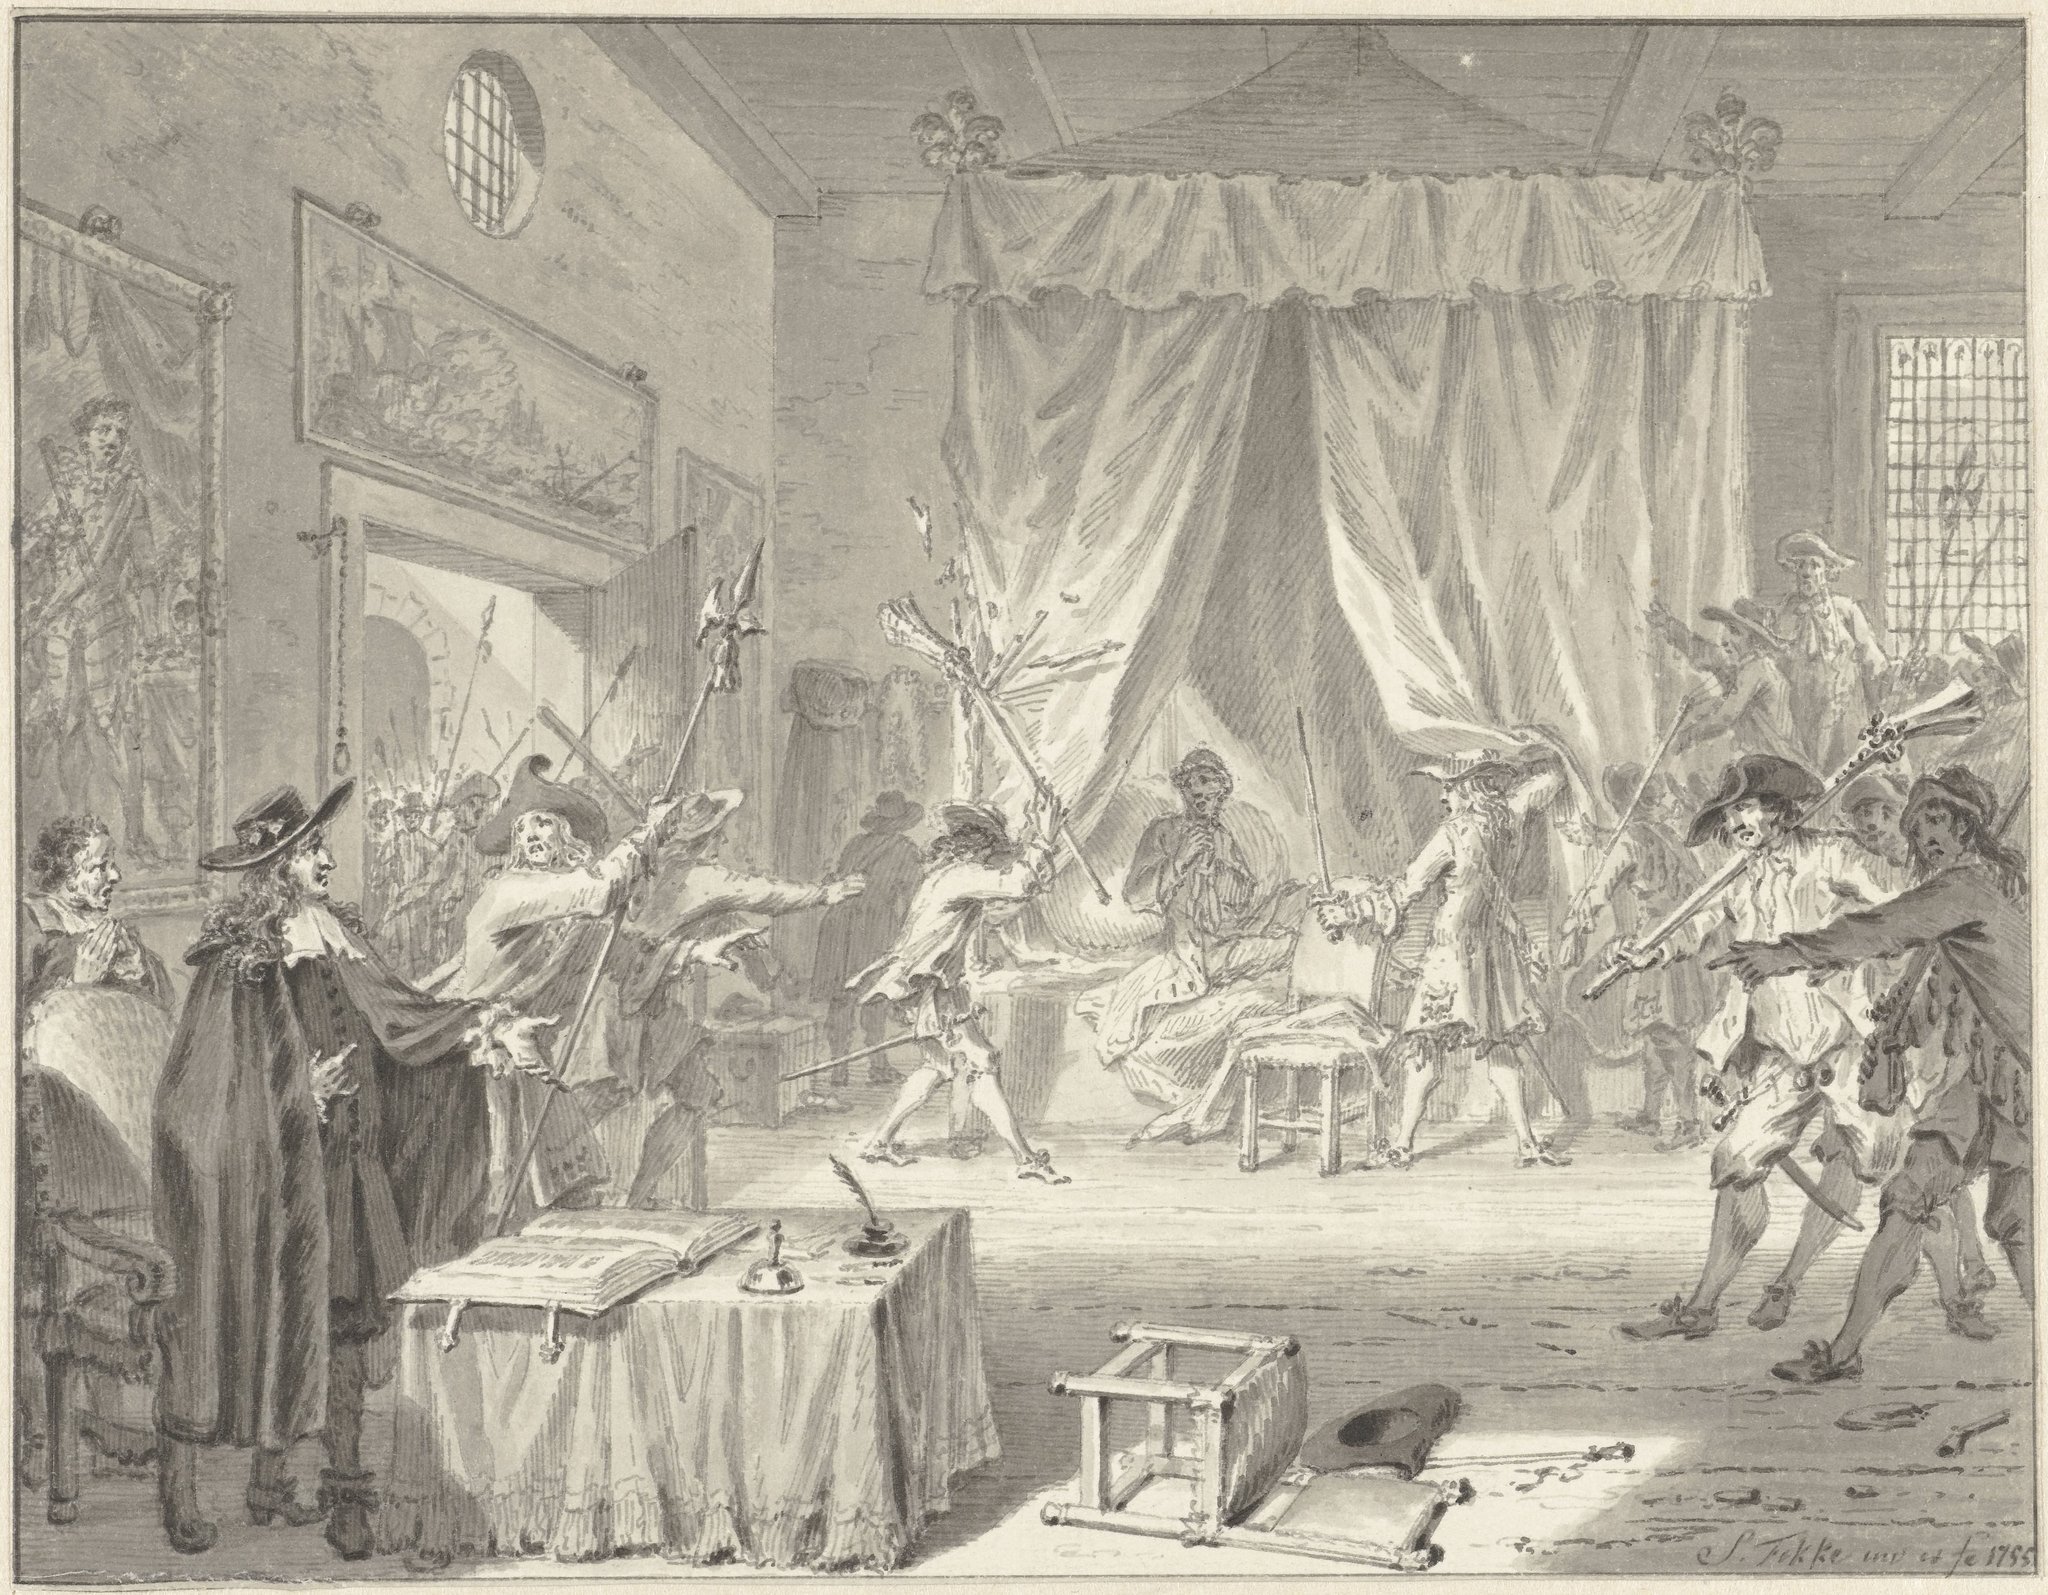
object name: design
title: De gebroeders Johan en Cornelis de Witt aangevallen in hun kamer boven de Voorpoort van de Gevangenpoort te 's-Gravenhage, 20 augustus 1672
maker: simon fokke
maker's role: draughtsman, print maker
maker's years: 1712-1784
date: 1755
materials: ink, paper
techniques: brush, pen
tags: cornelis de witt, politician, johan de witt, informal justice, self-help, historical persons, historical events and situations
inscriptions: date: ‘1755’